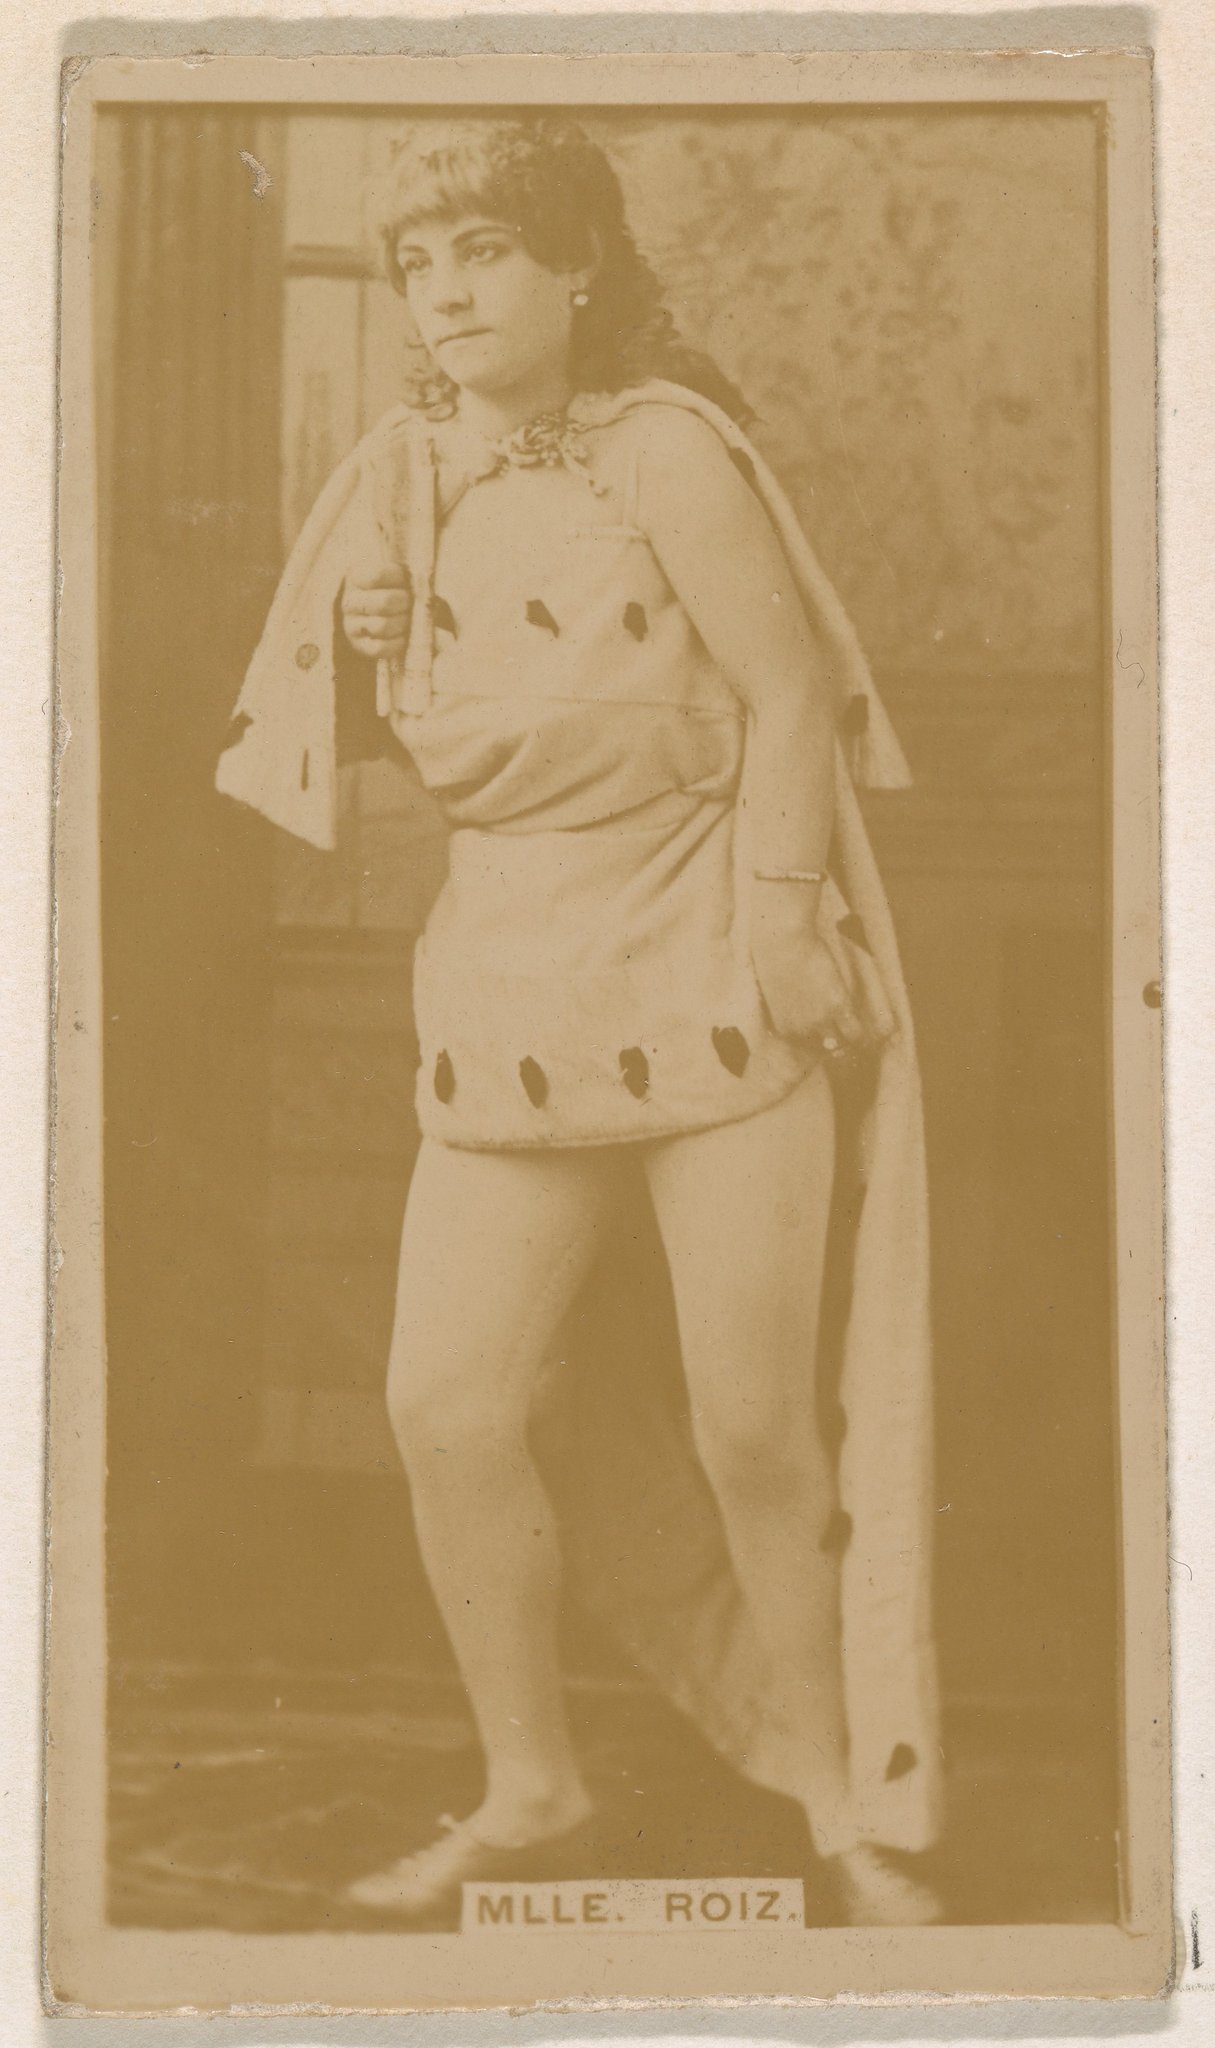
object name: photograph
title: Mlle. Roiz, from the Actresses series (N245) issued by Kinney Brothers to promote Sweet Caporal Cigarettes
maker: kinney brothers tobacco company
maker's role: publisher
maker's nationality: american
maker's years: 1869-2011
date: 1890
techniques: albumen silver print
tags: portraits,women,actresses